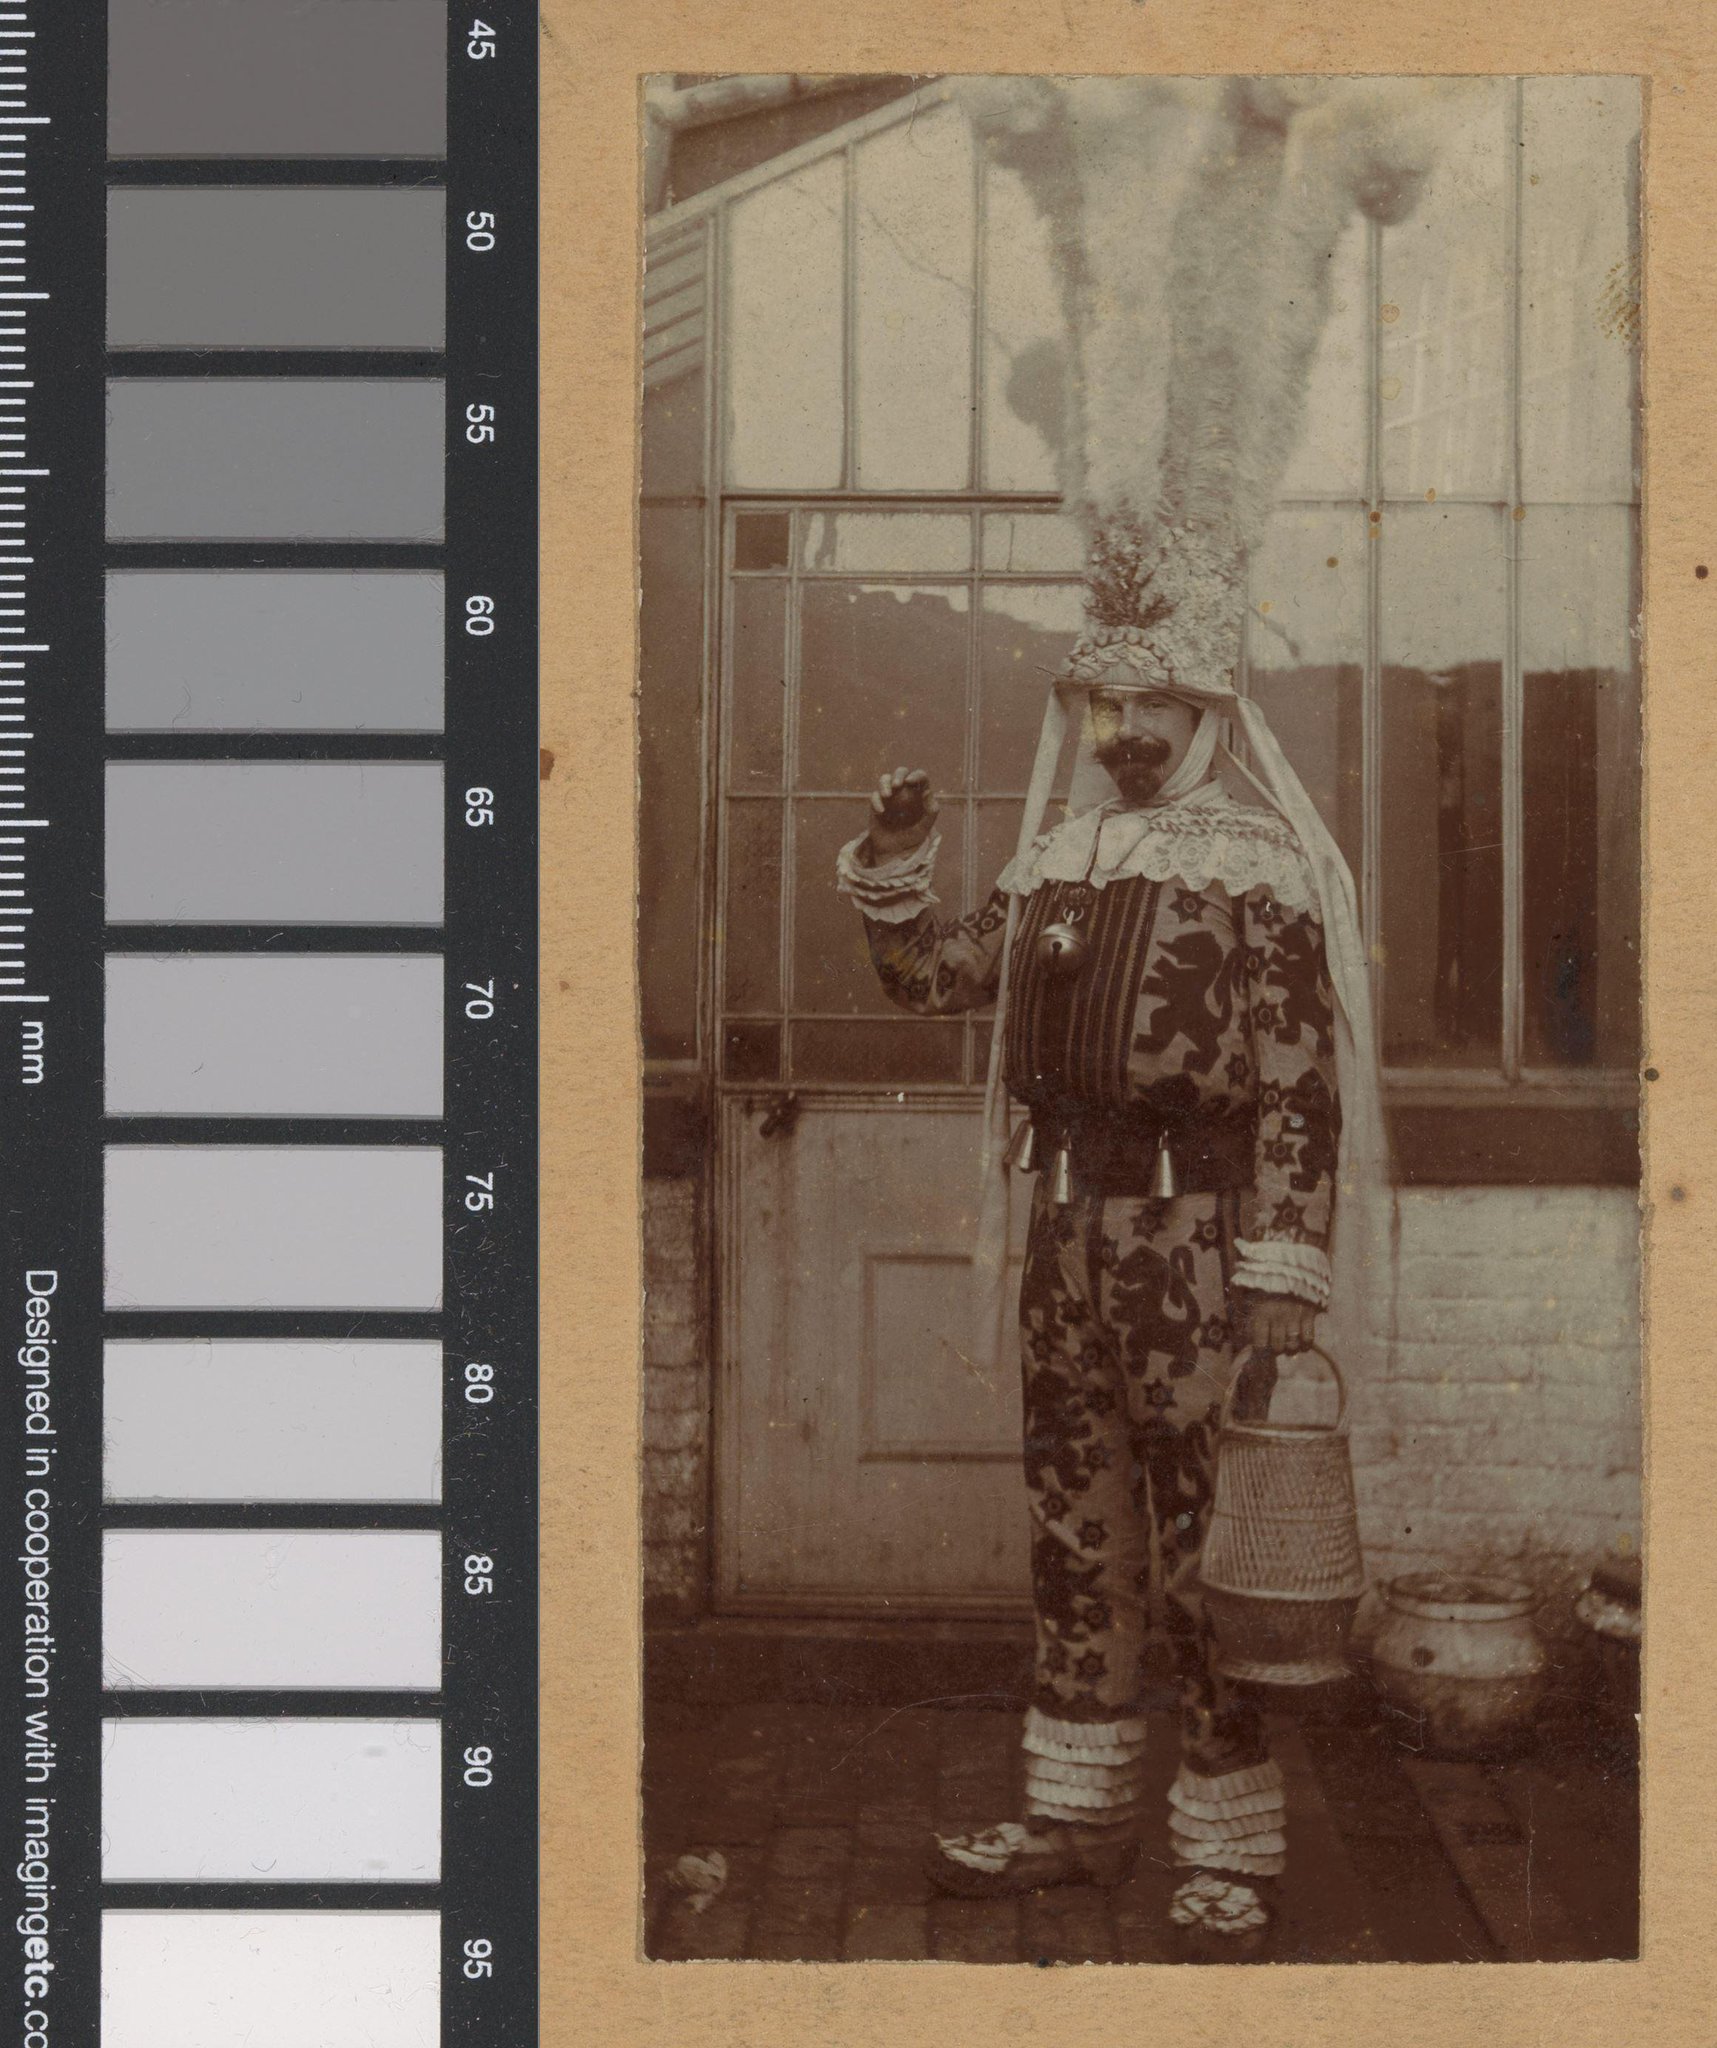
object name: photograph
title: Portret van een onbekende man in carnavalskostuum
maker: Anonymous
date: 1900-1910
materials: cardboard, photographic support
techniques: gelatin silver print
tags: adult man, carnival, shrovetide (non-liturgical celebration), fantasy costume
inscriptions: inscription: ‘Carnaval Haine 'd 'bierre 190[..] souvenir au carnaval Arma[...] [...] Burier’